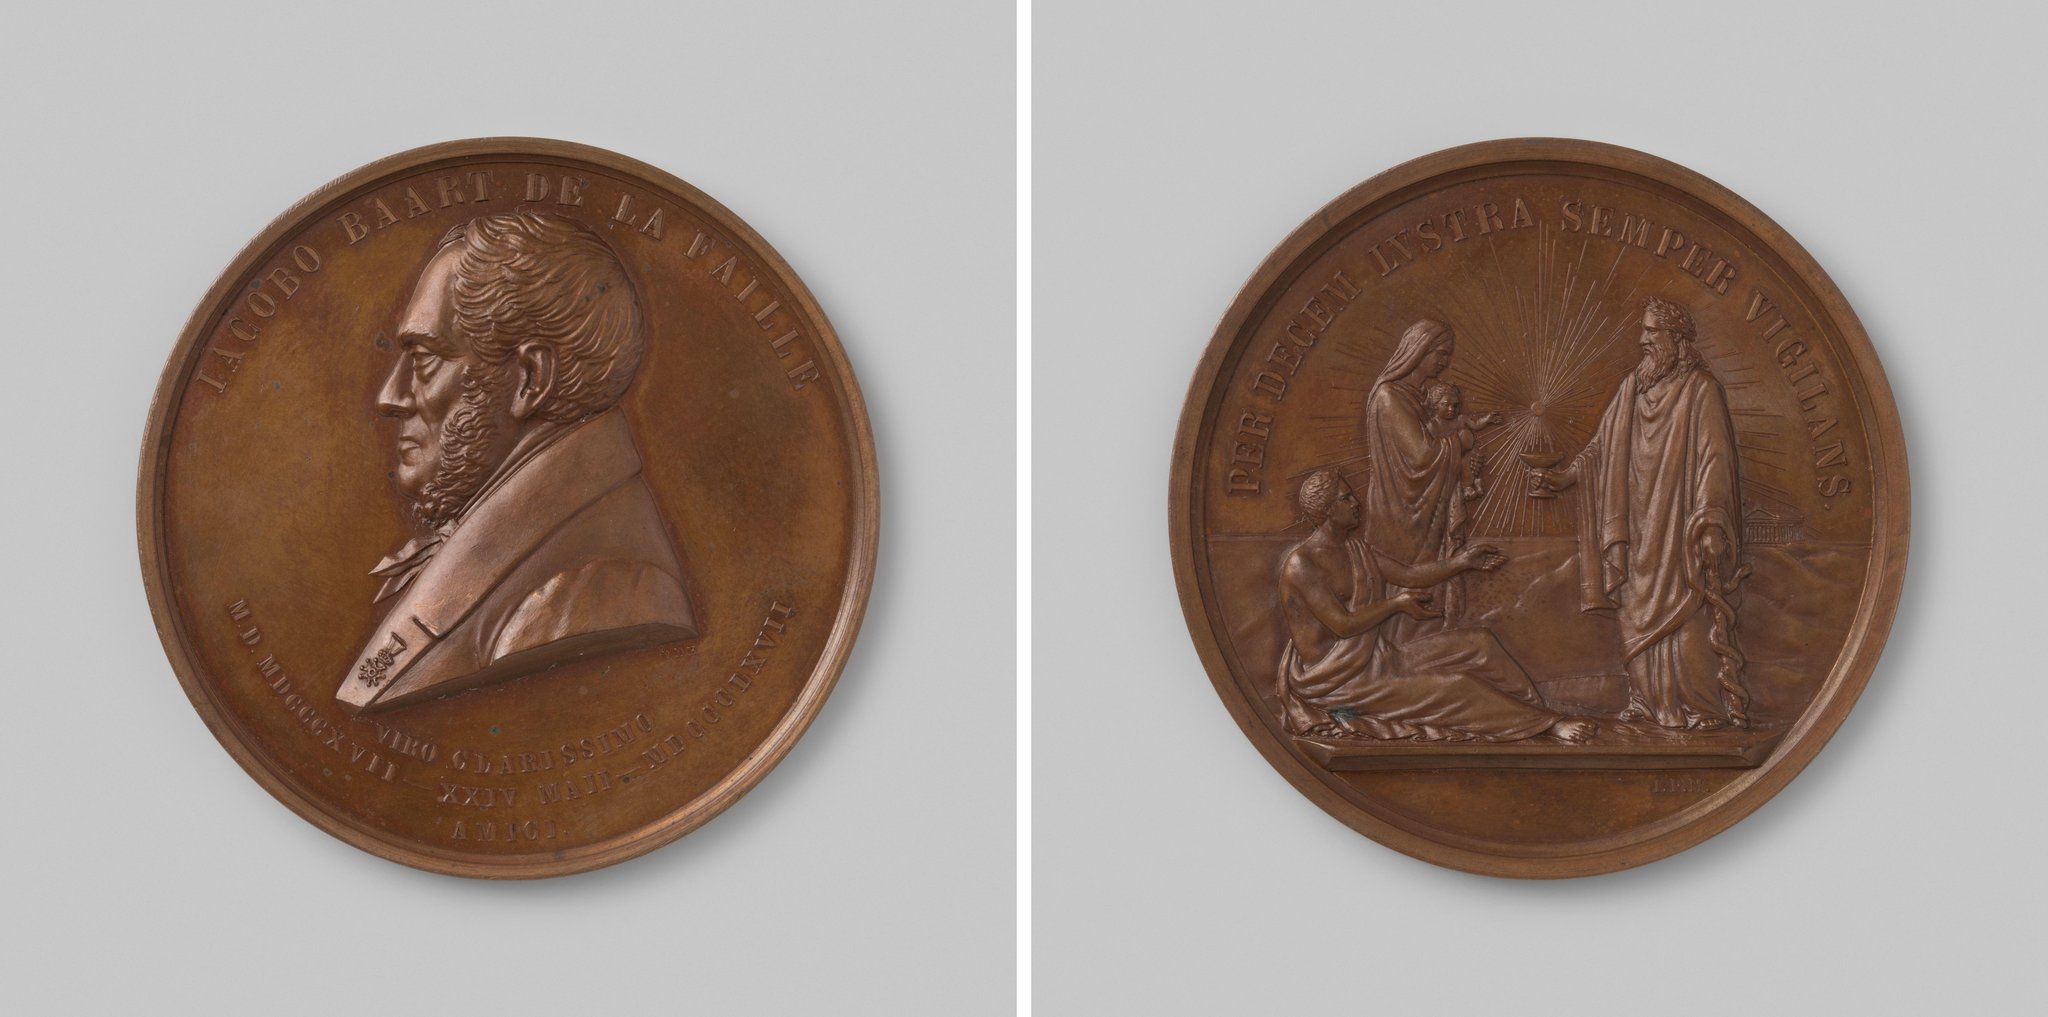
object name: honorary medal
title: Jacobus Baart de la Faille, vijftig jaar hoogleraar in de medische wetenschap te Groningen, penning geschonken door zijn vrienden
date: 1867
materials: bronze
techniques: striking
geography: utrecht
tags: hoogleraar, geneeskundige, arts, jacob ii baart de la faille, rijksuniversiteit groningen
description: Bronzen penning. Voorzijde: borststuk man binnen omschrift. Keerzijde: Aesculapius met slangestaf in linkerhand, reikt beker aan gesluierde vrouw met kind op arm en zittende man, die armen uitgestrekt houdt; op achtergrond stralende zon en tempel in berglandschap binnen omschrift